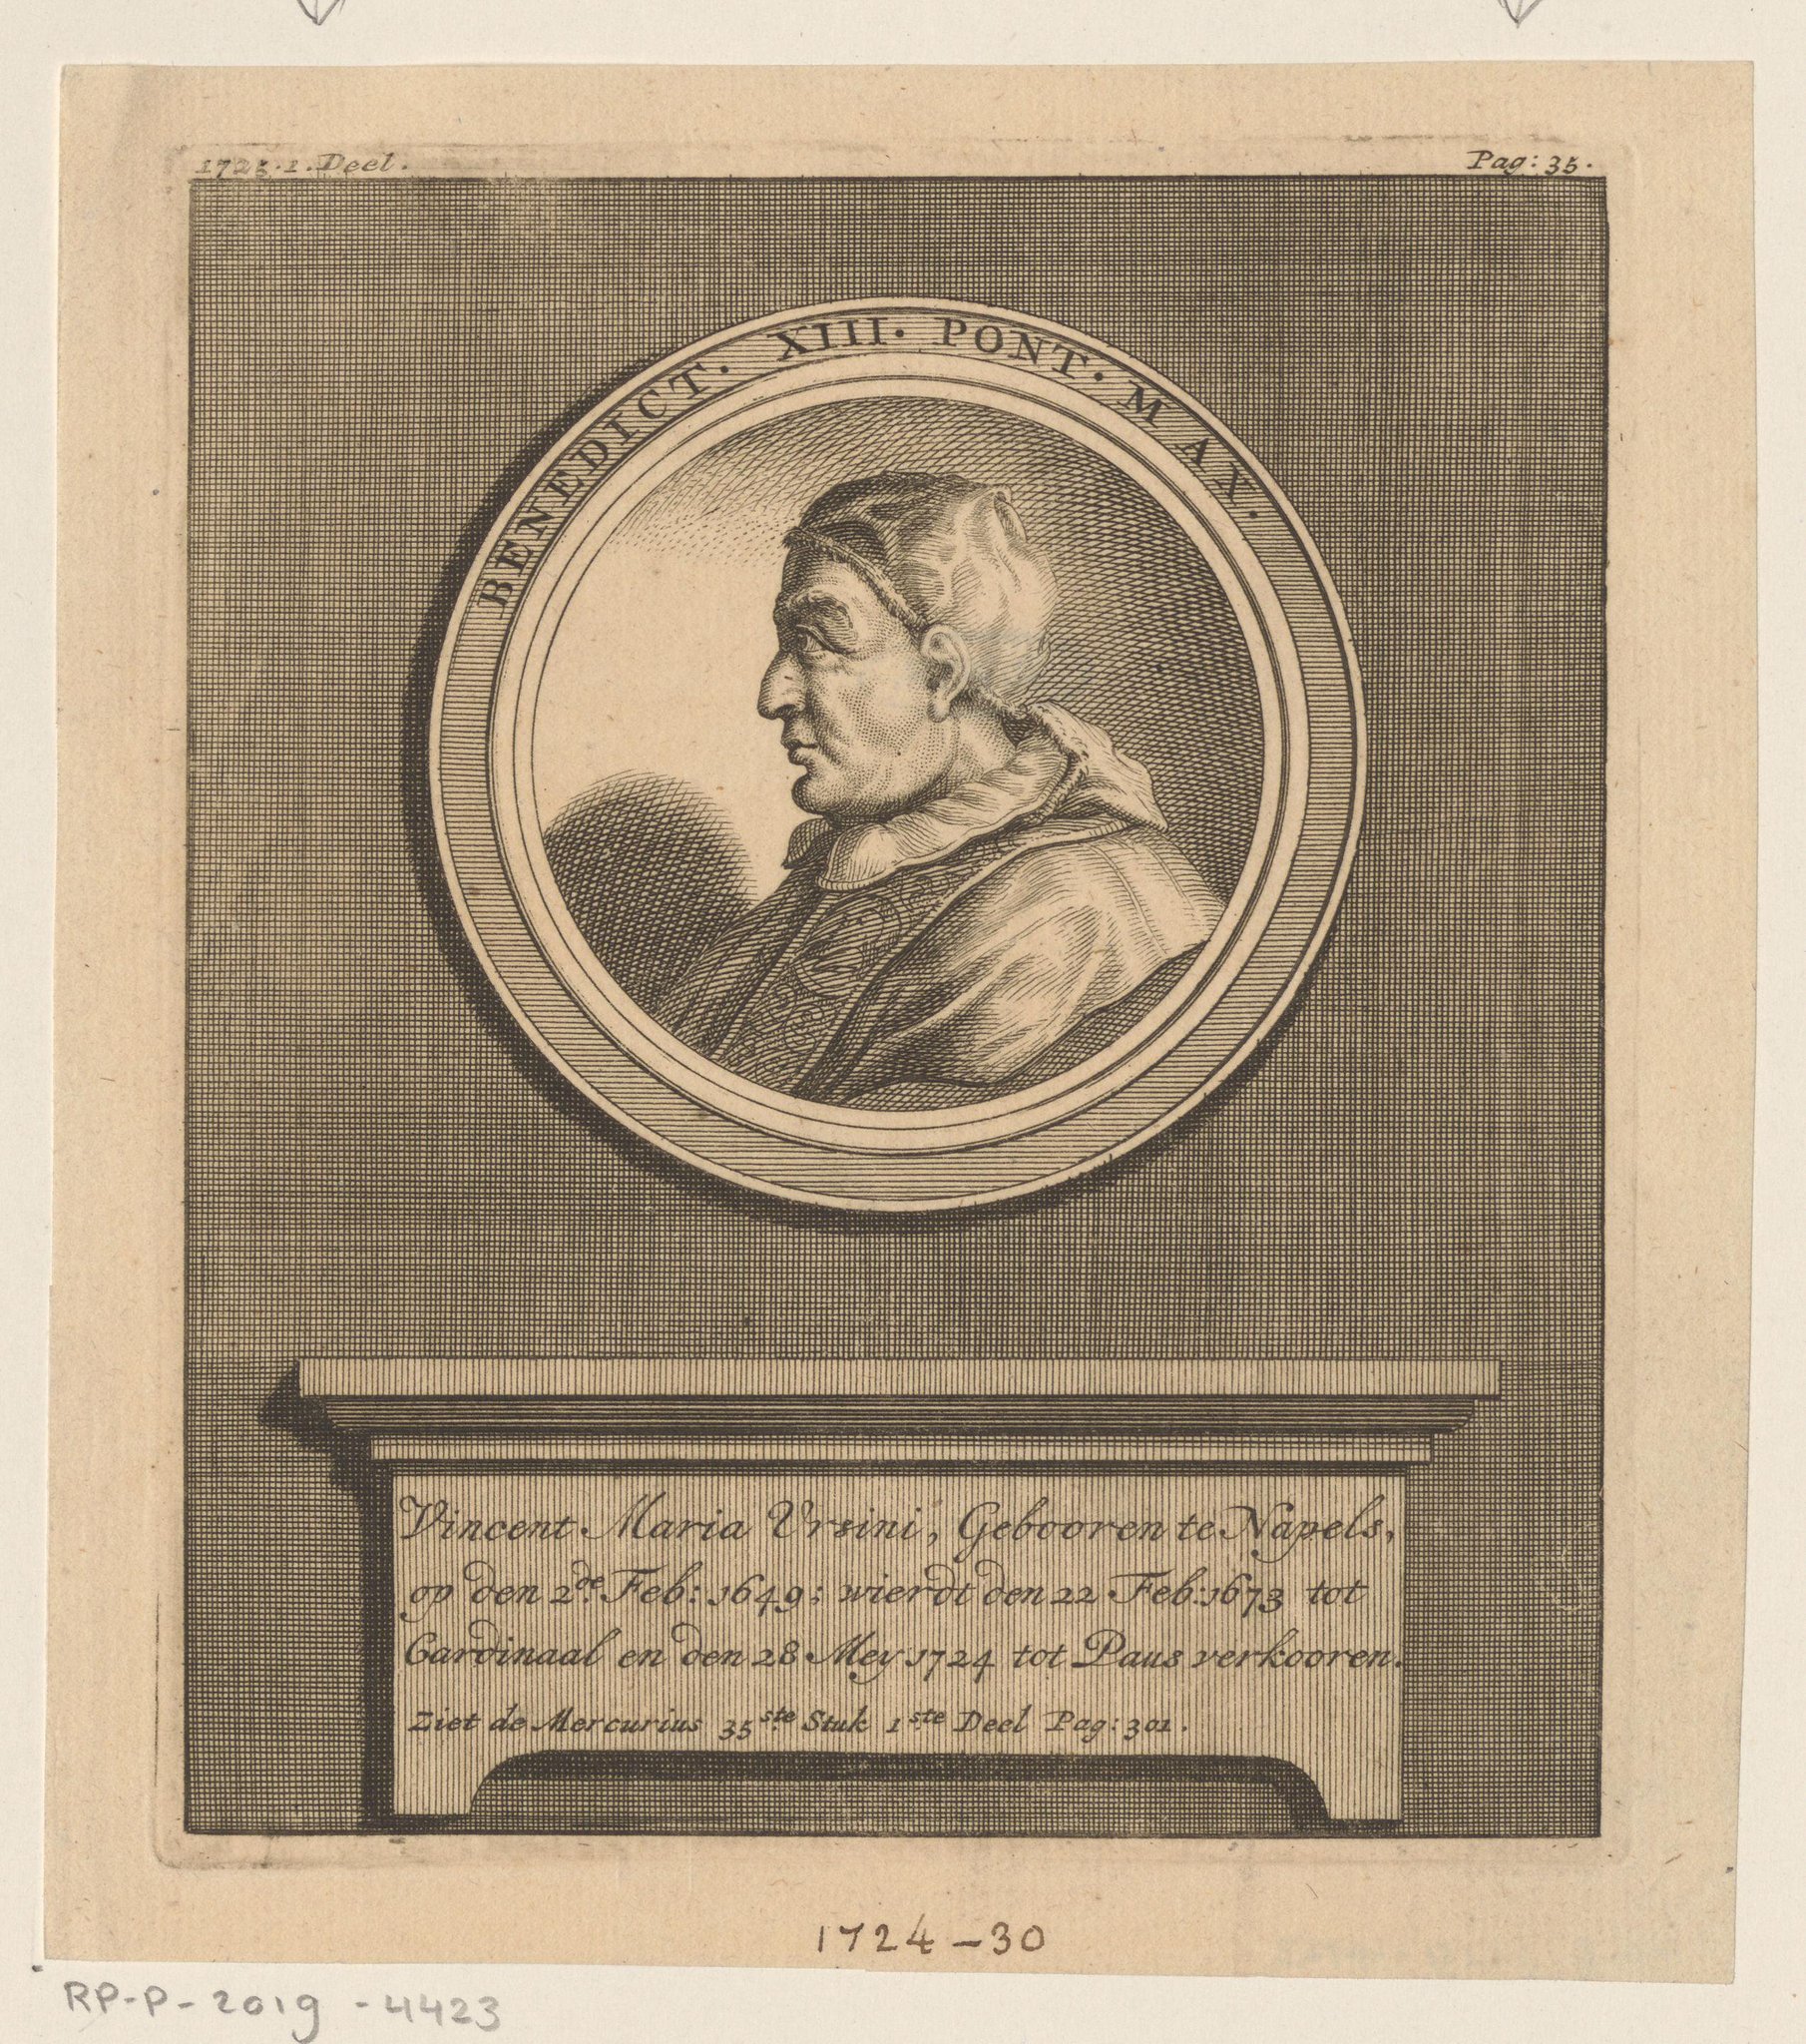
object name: print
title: Portret van paus Benedictus XIII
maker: Anonymous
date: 1725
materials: paper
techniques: engraving, etching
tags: benedictus xiii, historical persons, pope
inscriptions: collector's mark: Lugt 2228, inscription: ‘1724-30’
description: Links- en rechtsboven genummerd: 1 Deel. Pag. 35.